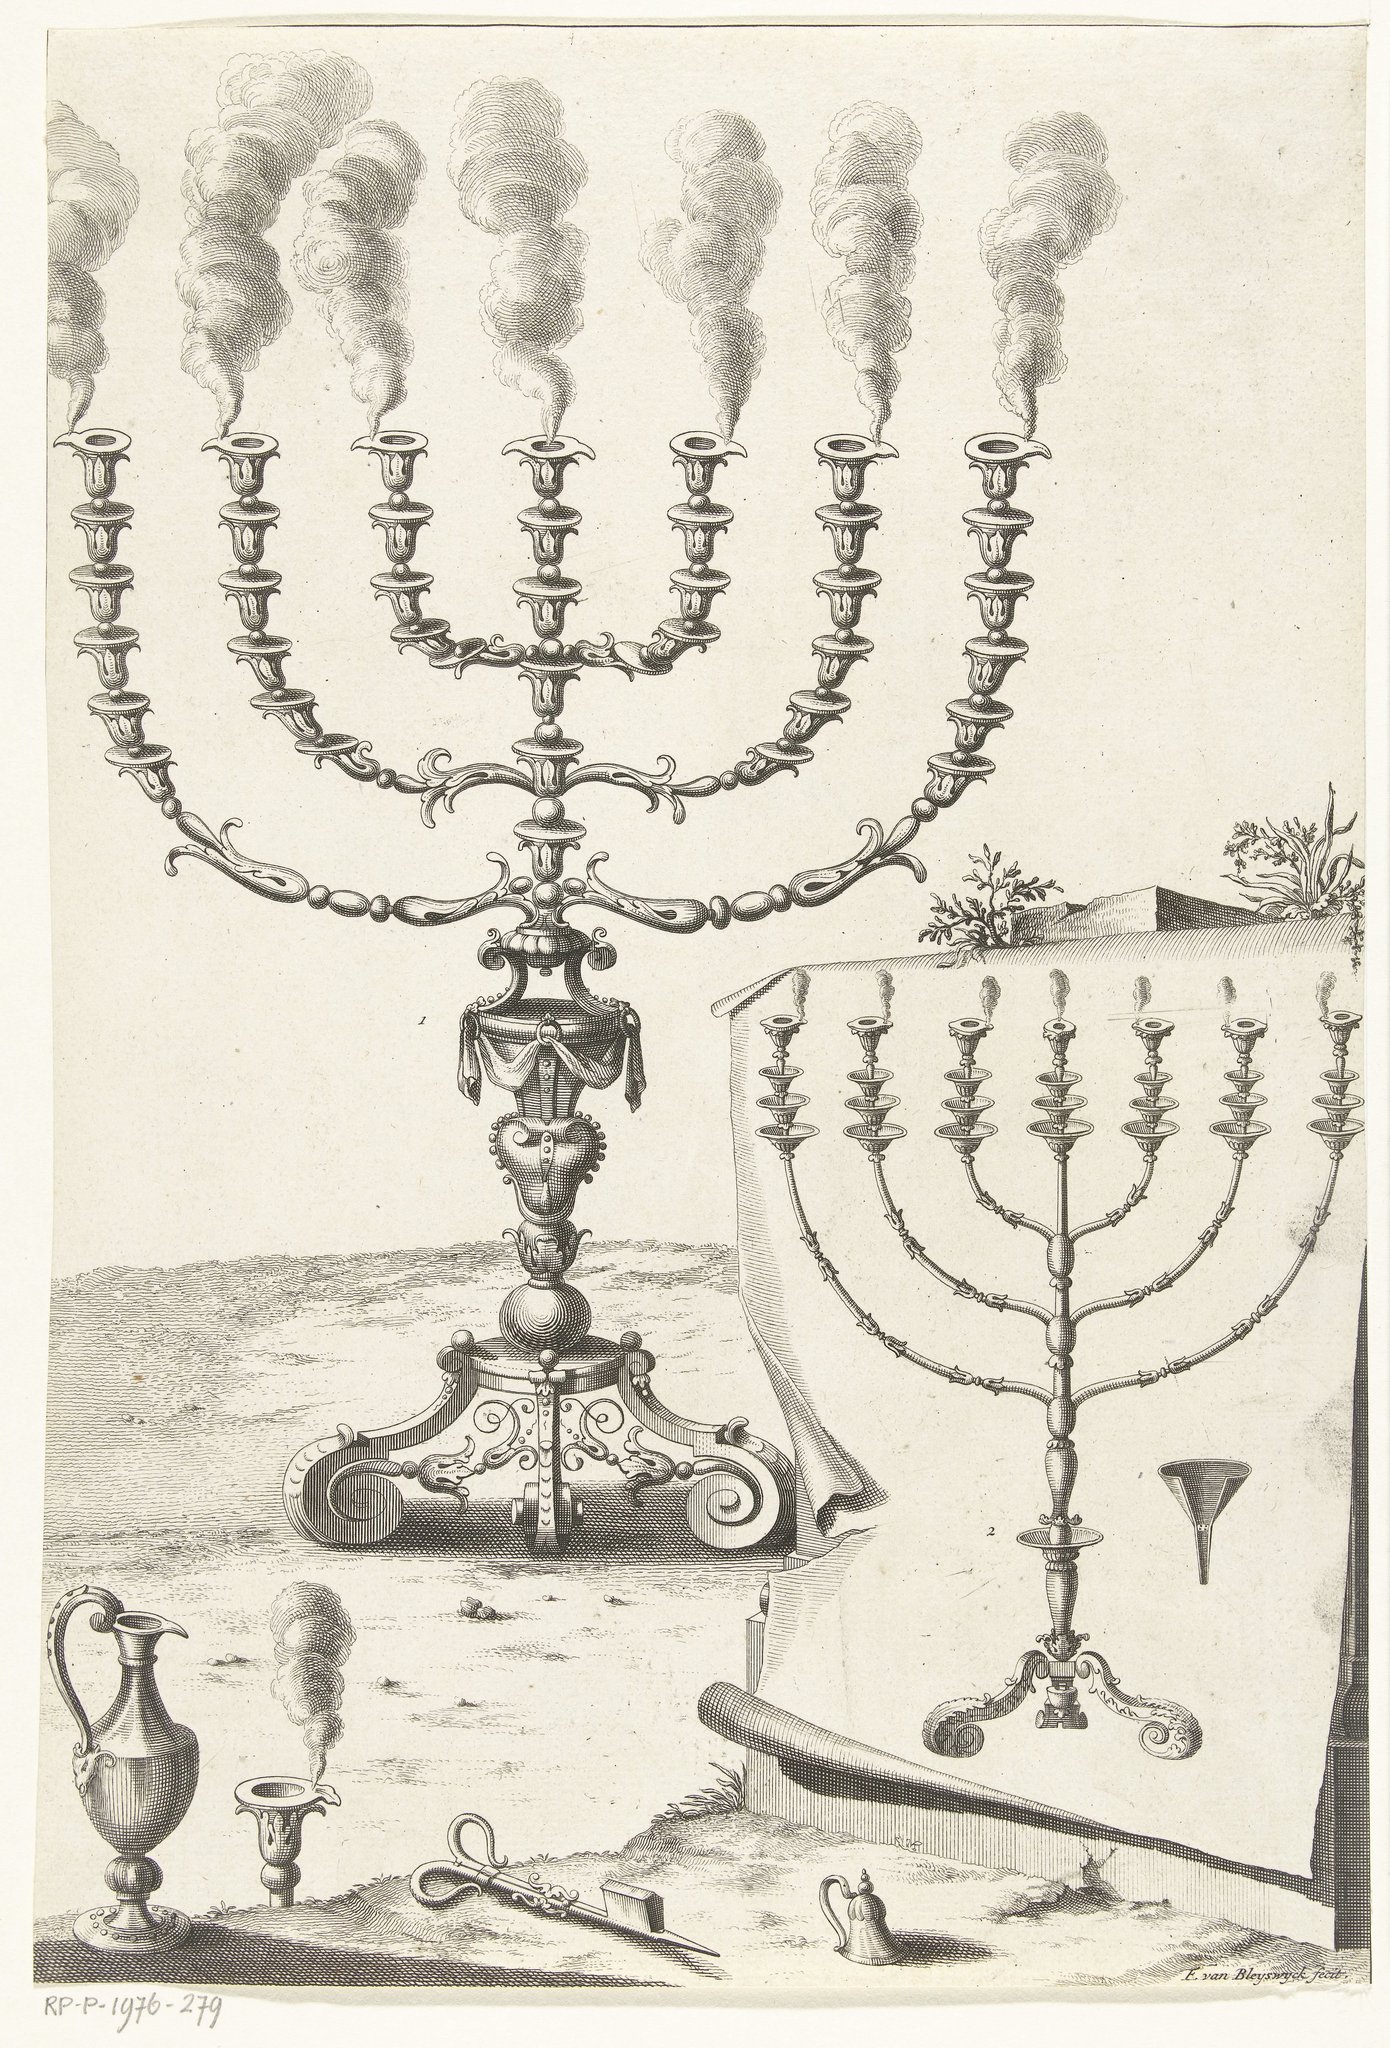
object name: book illustration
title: Gouden zevenarmige kandelaar of menora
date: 1681-1746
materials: paper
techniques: engraving, etching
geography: the hague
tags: 'menorah', golden seven-branched candlestick, kept in the tabernacle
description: Prent mogelijk voor: Hoet, Gerard, Taferelen der voornaamste geschiedenissen van het Oude en Nieuwe Testament, en andere boeken, bij de Heilige Schrift gevoegt, door Hoet, Houbraken, en Picart getekent en van de beste meesters in koper gesneden en met beschrijvingen uitgebreid, 3 delen, 's-Gravenhage, Pieter de Hondt, 1728